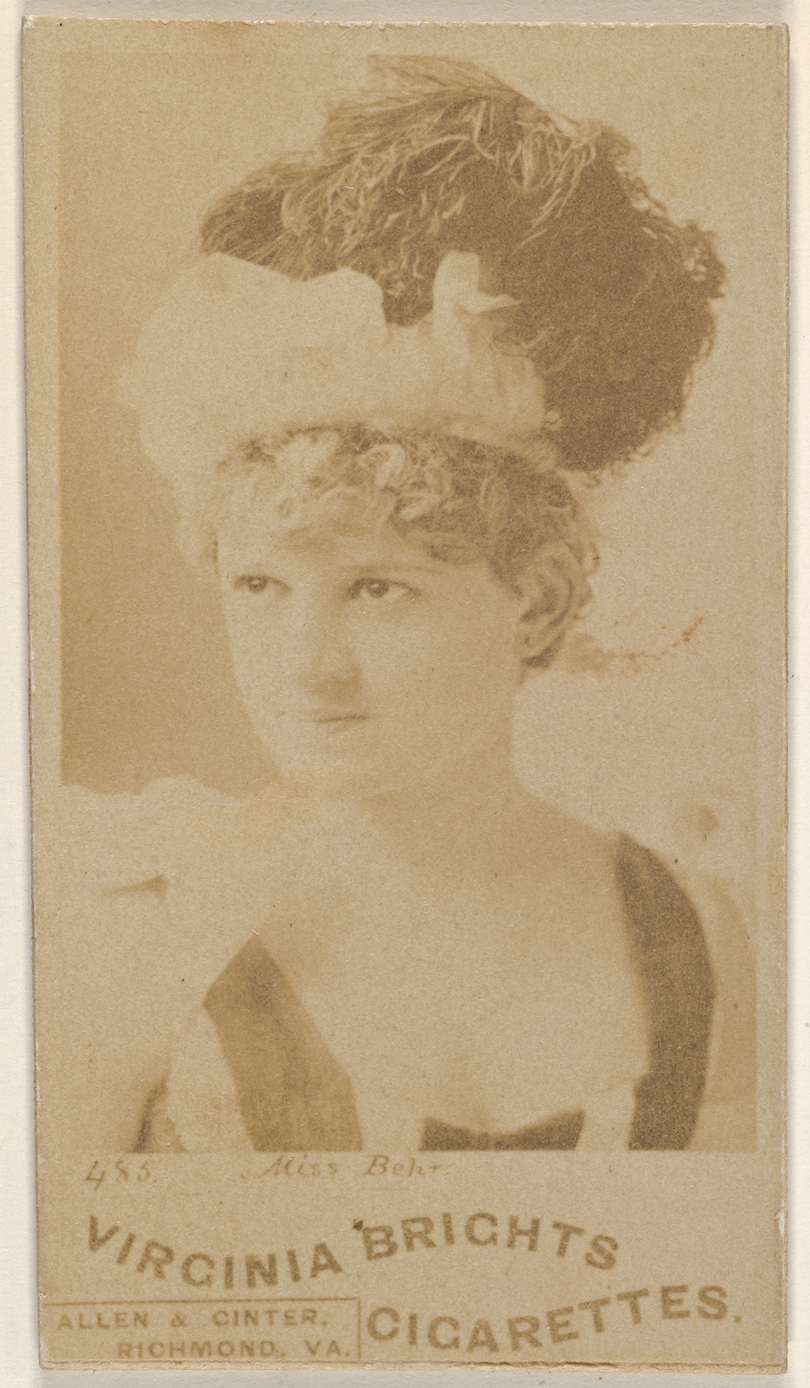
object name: photograph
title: Card 485, Miss Behr, from the Actors and Actresses series (N45, Type 1) for Virginia Brights Cigarettes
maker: allen & ginter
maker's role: publisher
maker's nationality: american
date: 1888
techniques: albumen silver print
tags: portraits,women,actresses